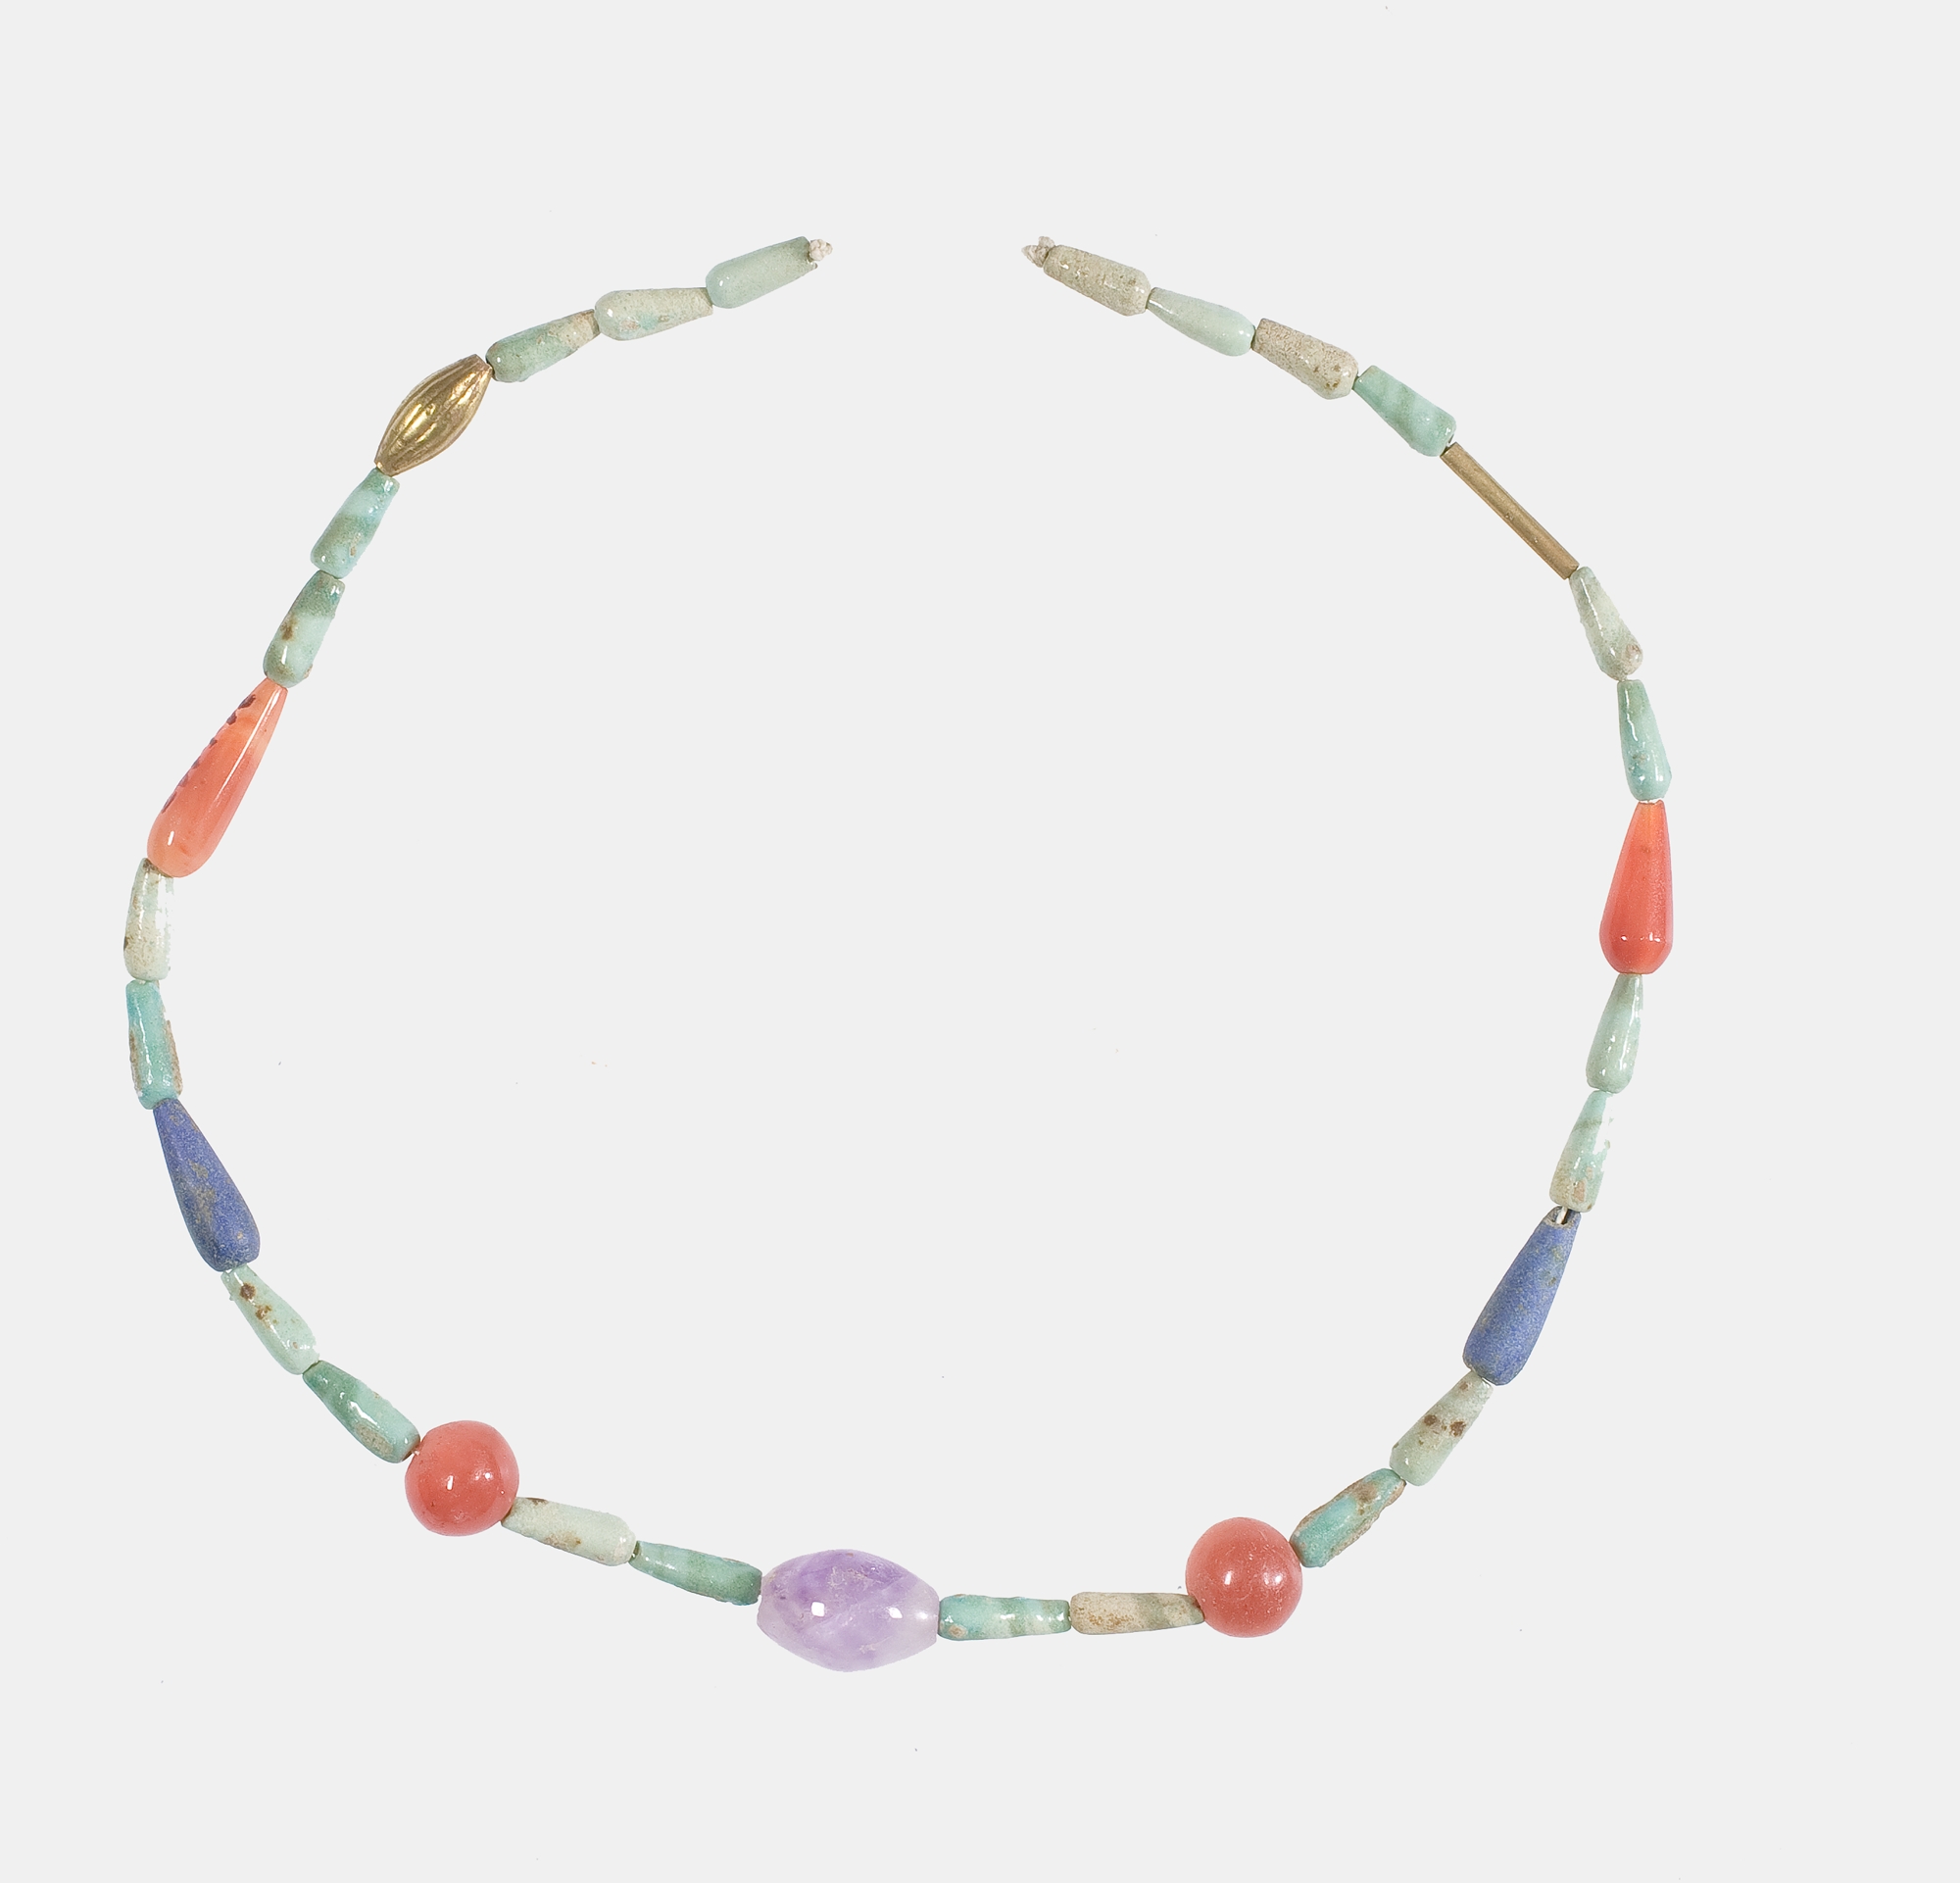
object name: bead, string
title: Hepy, String of beads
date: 1950-1885 BCE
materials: gemstone, faience, gold, lapis lazuli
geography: egypt